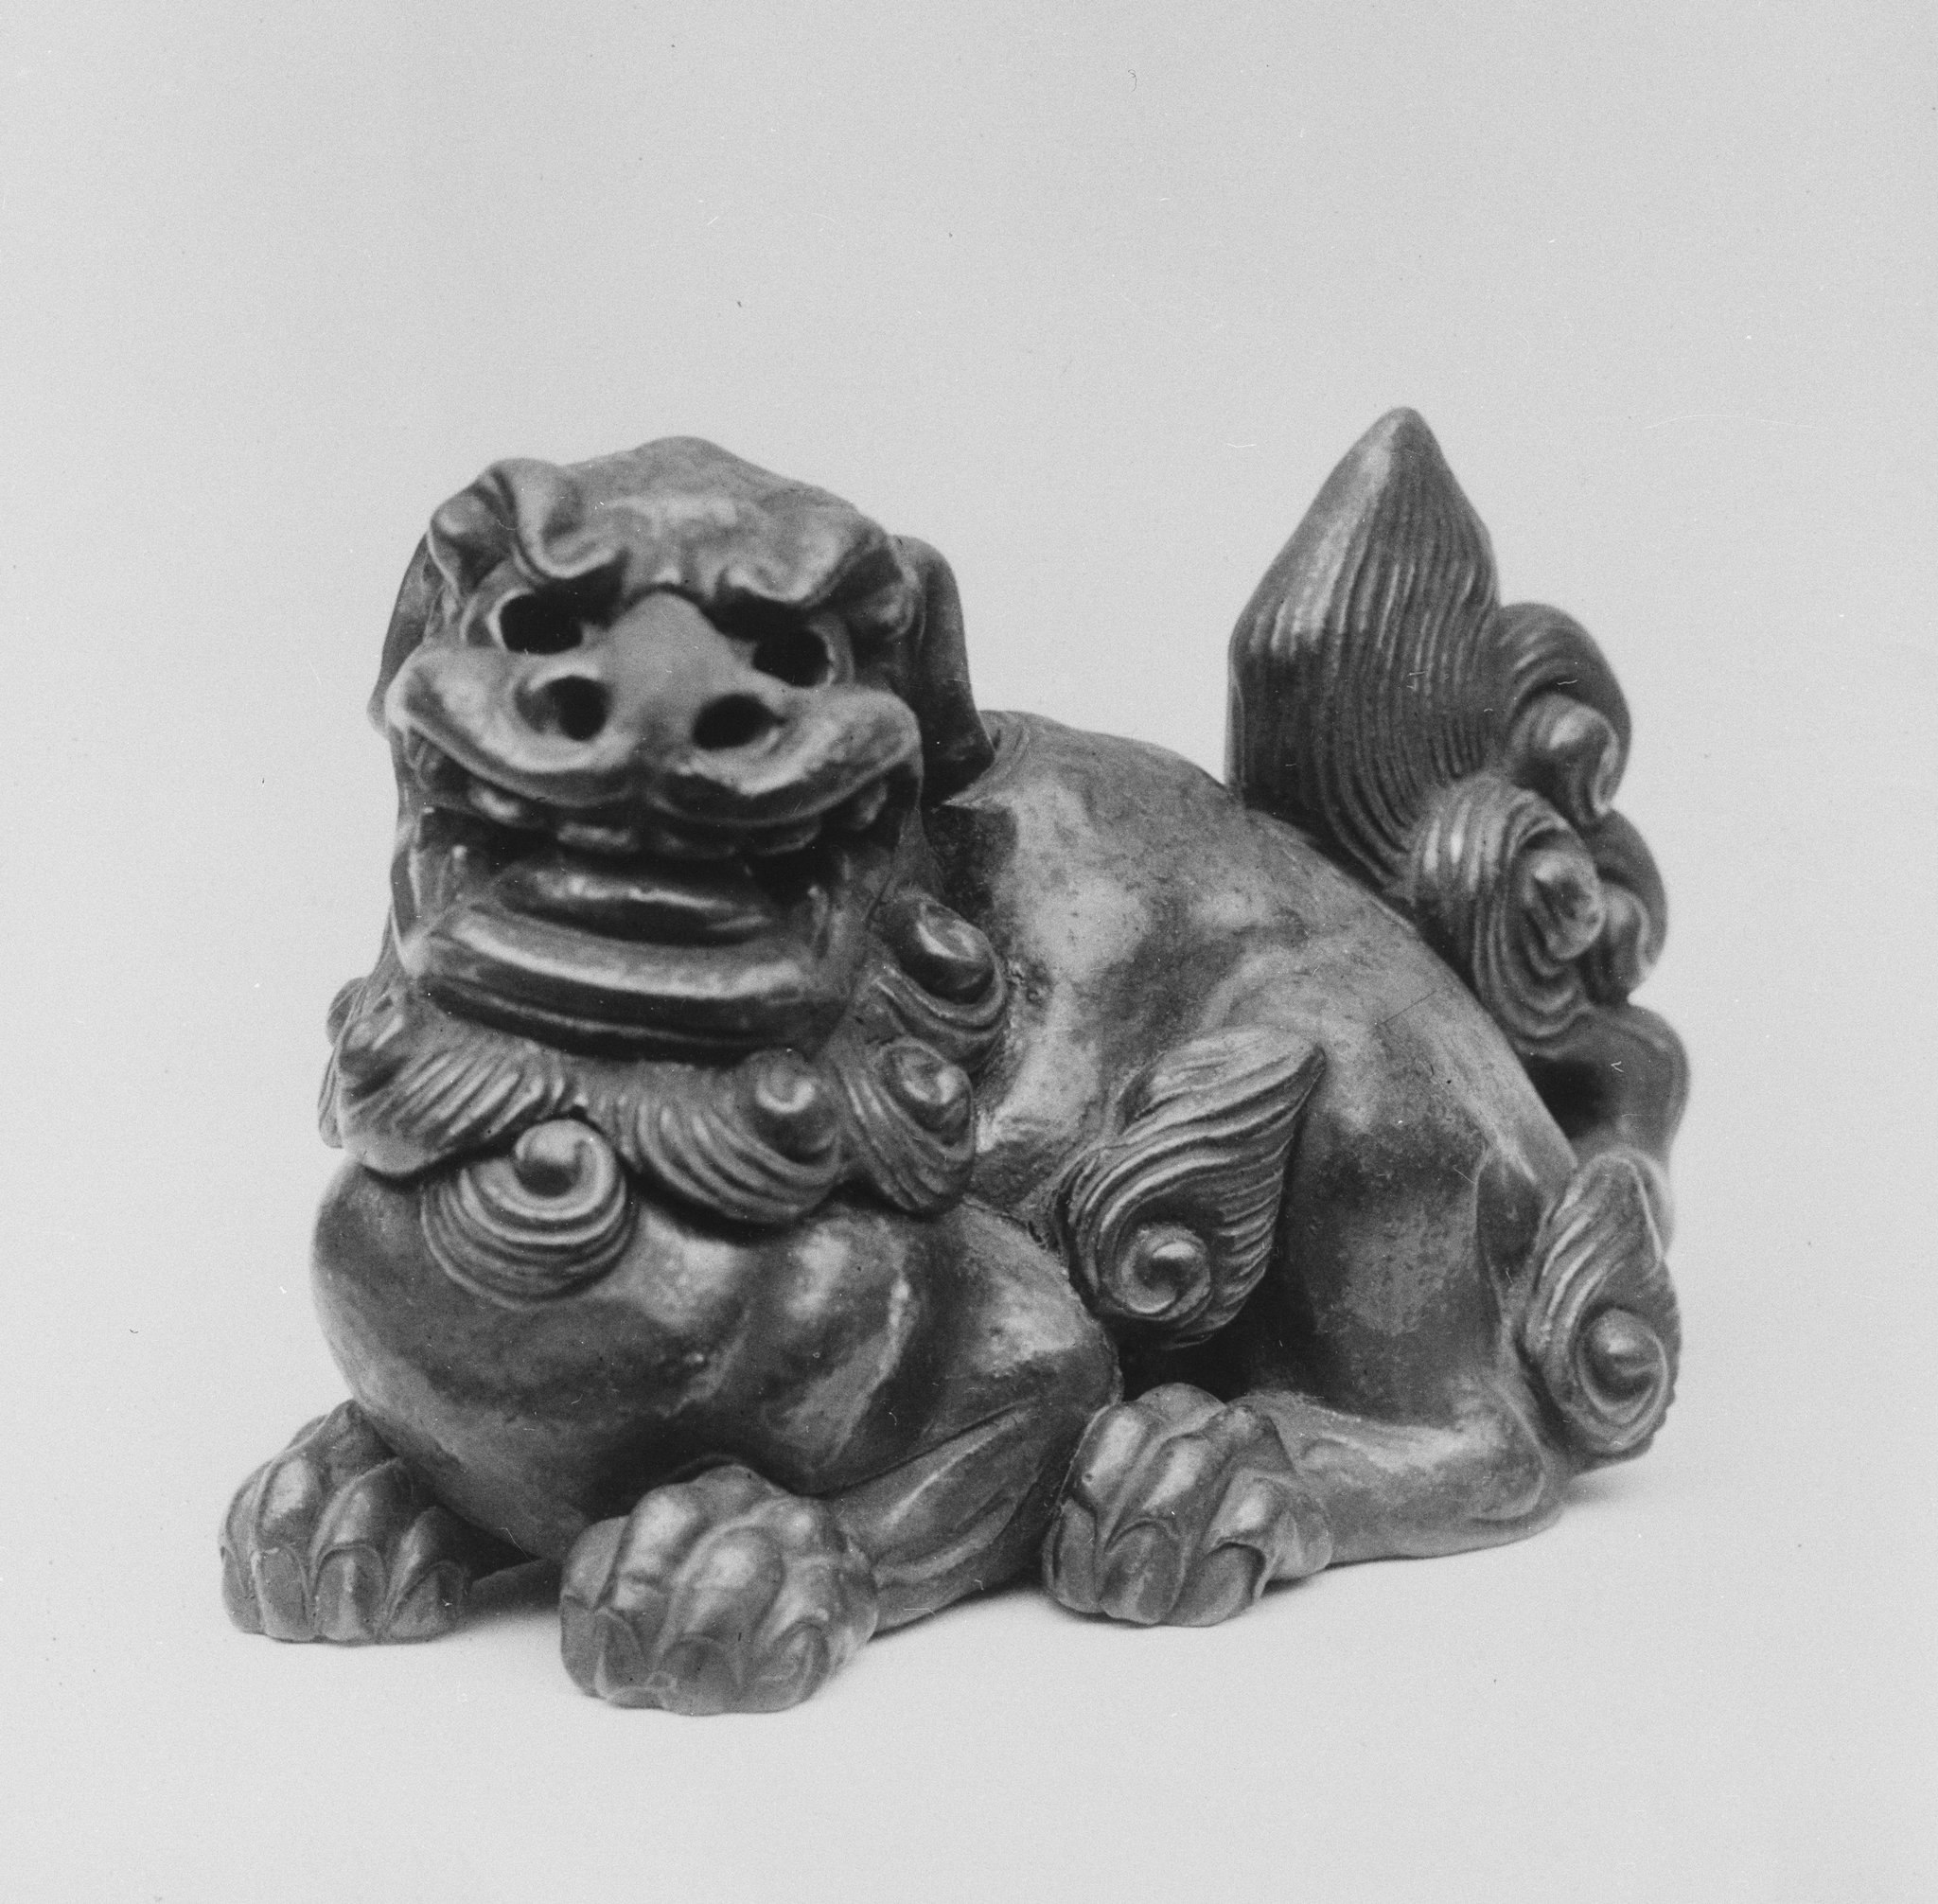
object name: censer with cover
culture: japanese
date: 1750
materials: glaze, stoneware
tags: animals,censers